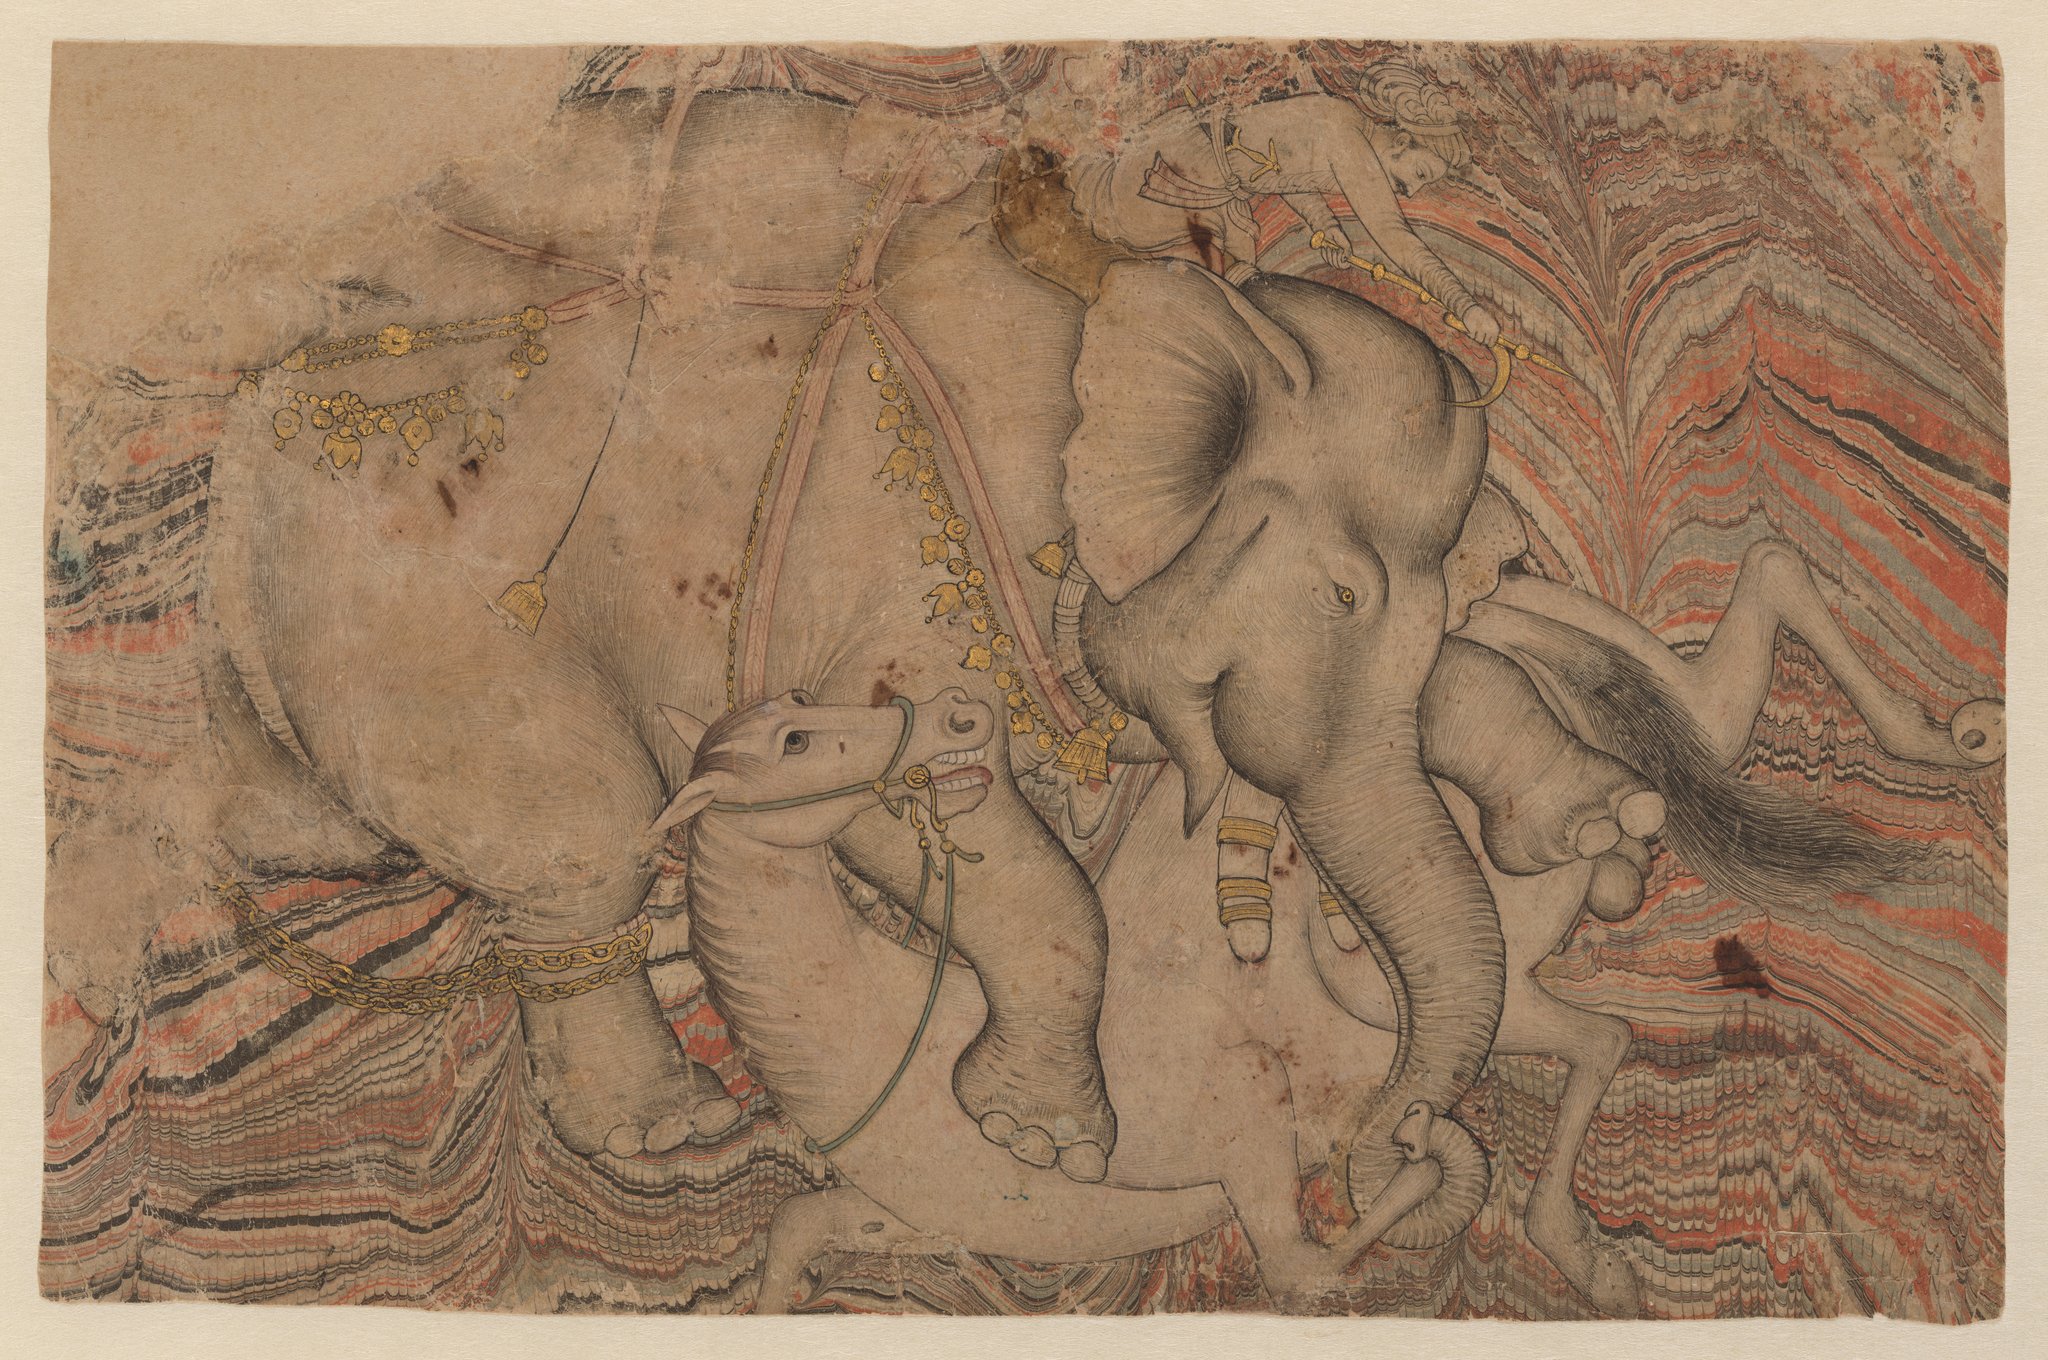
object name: illustrated album leaf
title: Elephant Trampling a Horse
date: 1634-1666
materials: gold, watercolor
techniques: marbling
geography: india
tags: elephants,horses